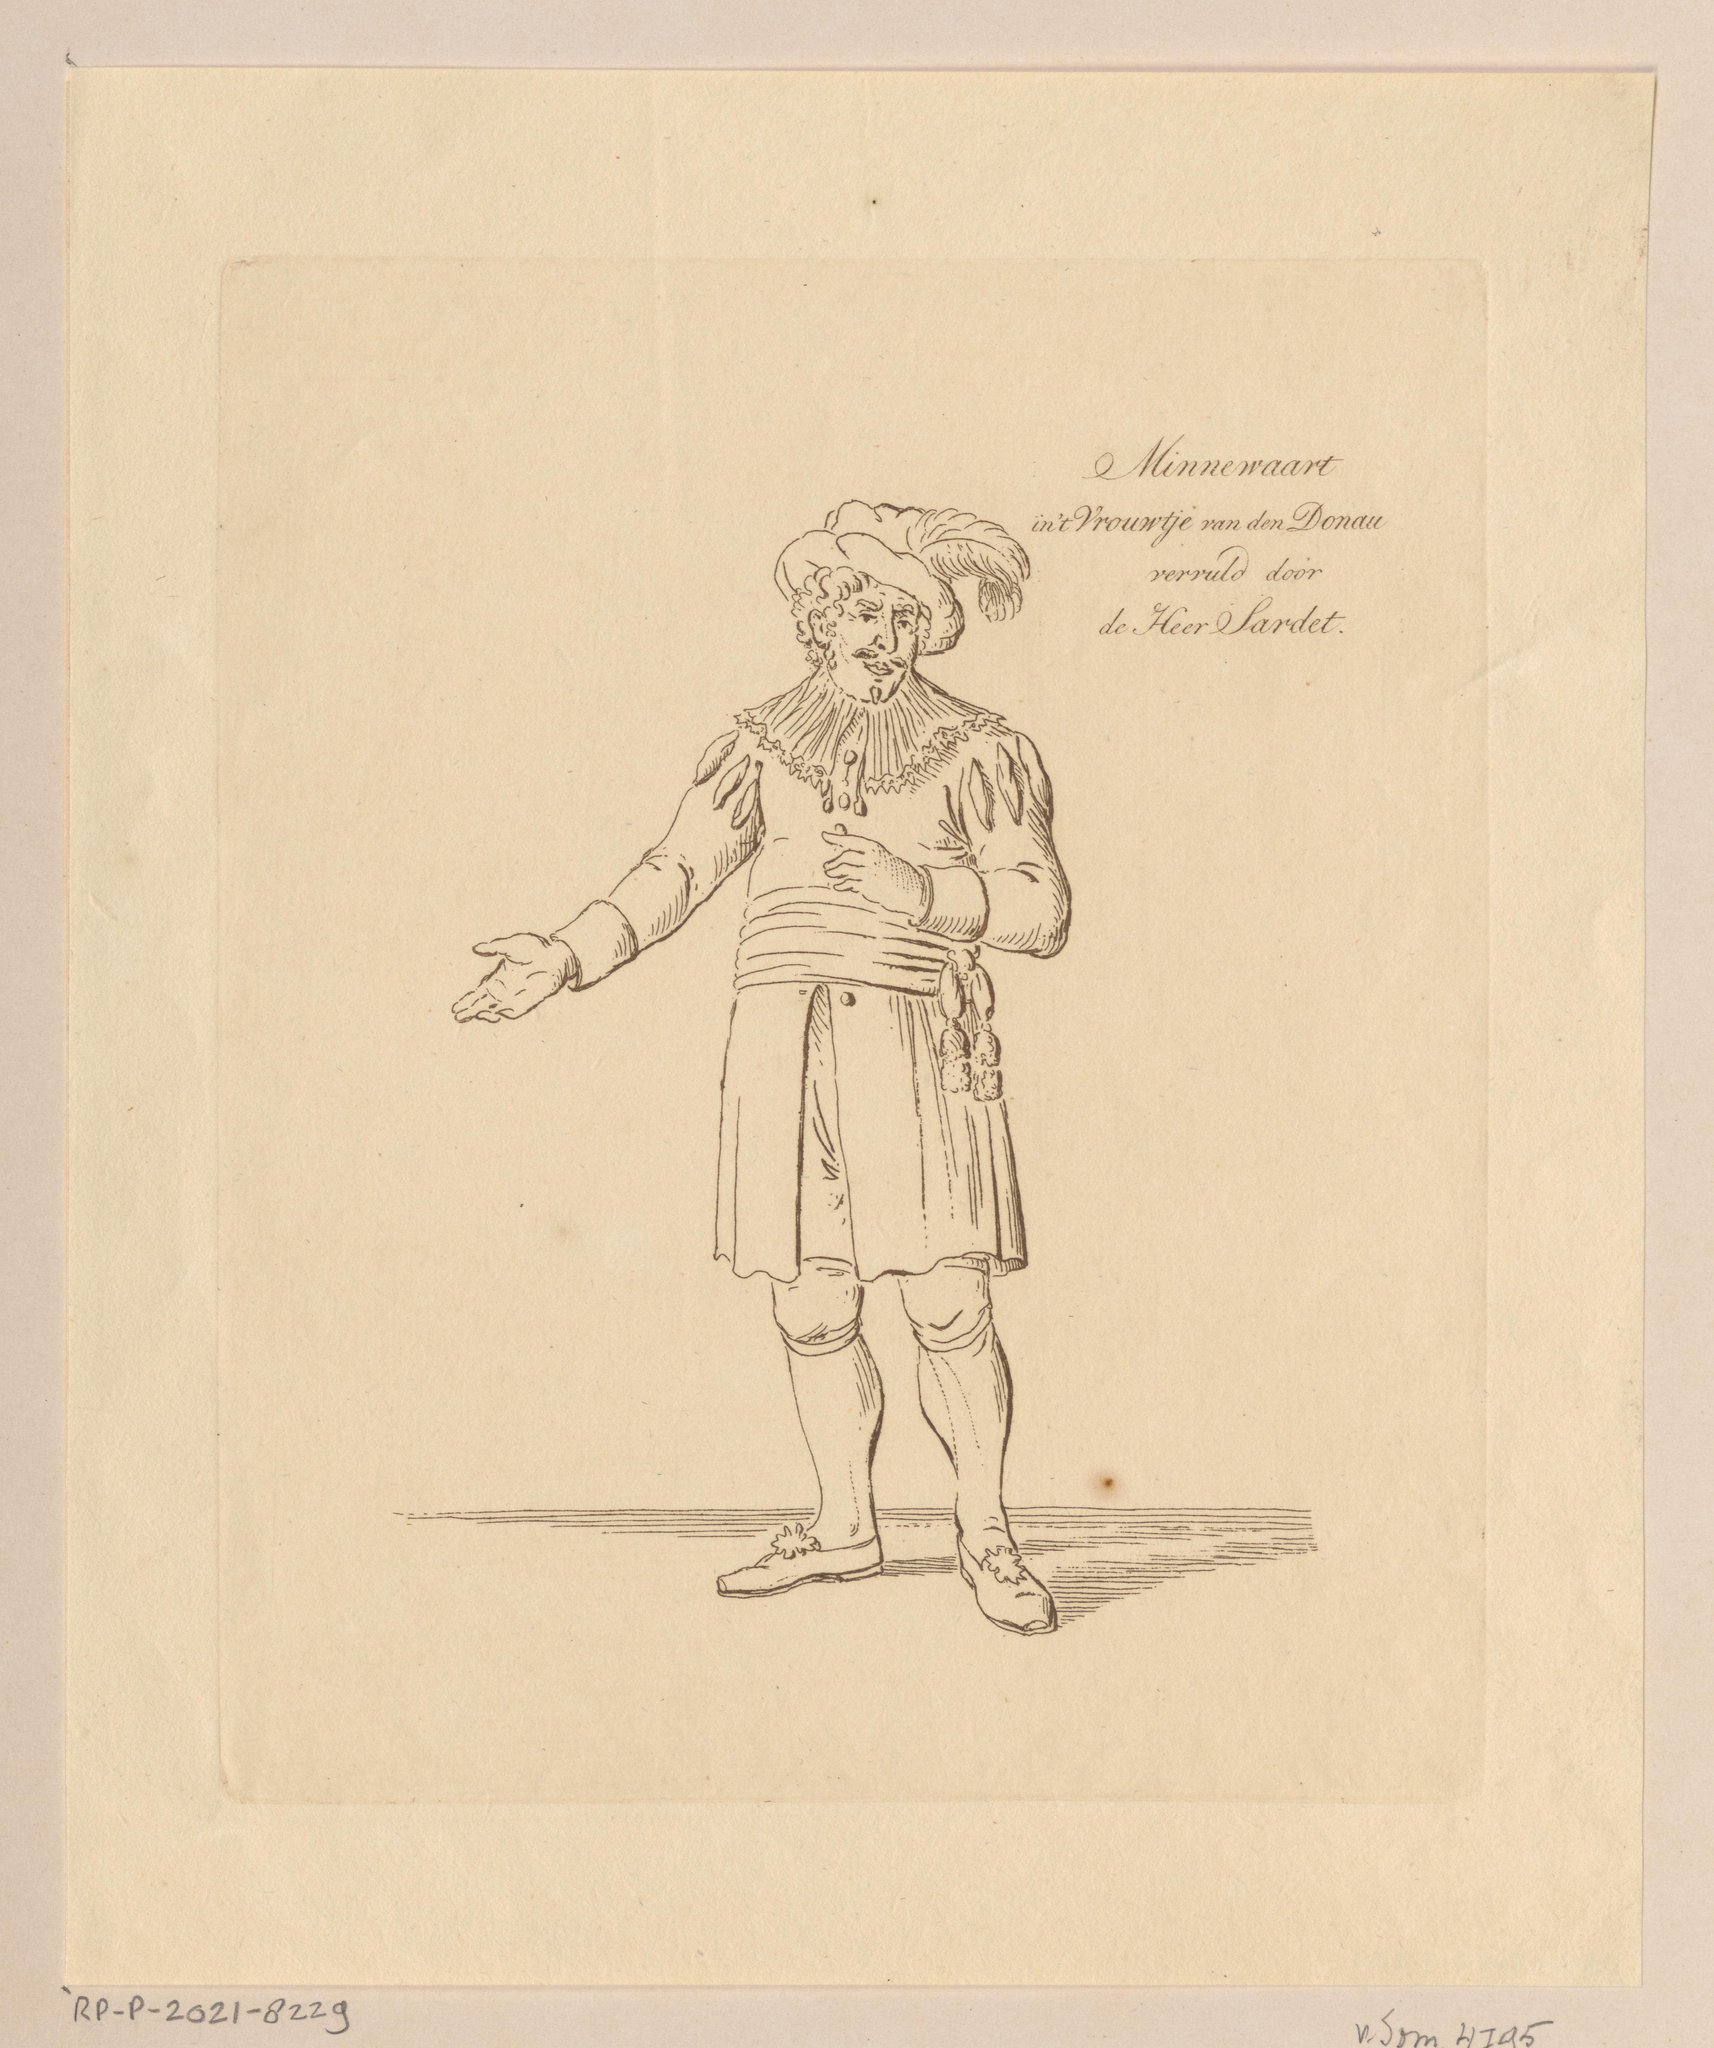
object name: print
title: Portret van Dirk Sardet in de rol van Minnewaart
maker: johannes jelgerhuis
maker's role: draughtsman, painter, print maker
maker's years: 1770-1836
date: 1736-1780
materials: paper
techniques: etching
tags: dirk sardet, historical persons, actor (on the stage)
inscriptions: inscription: ‘P9761’